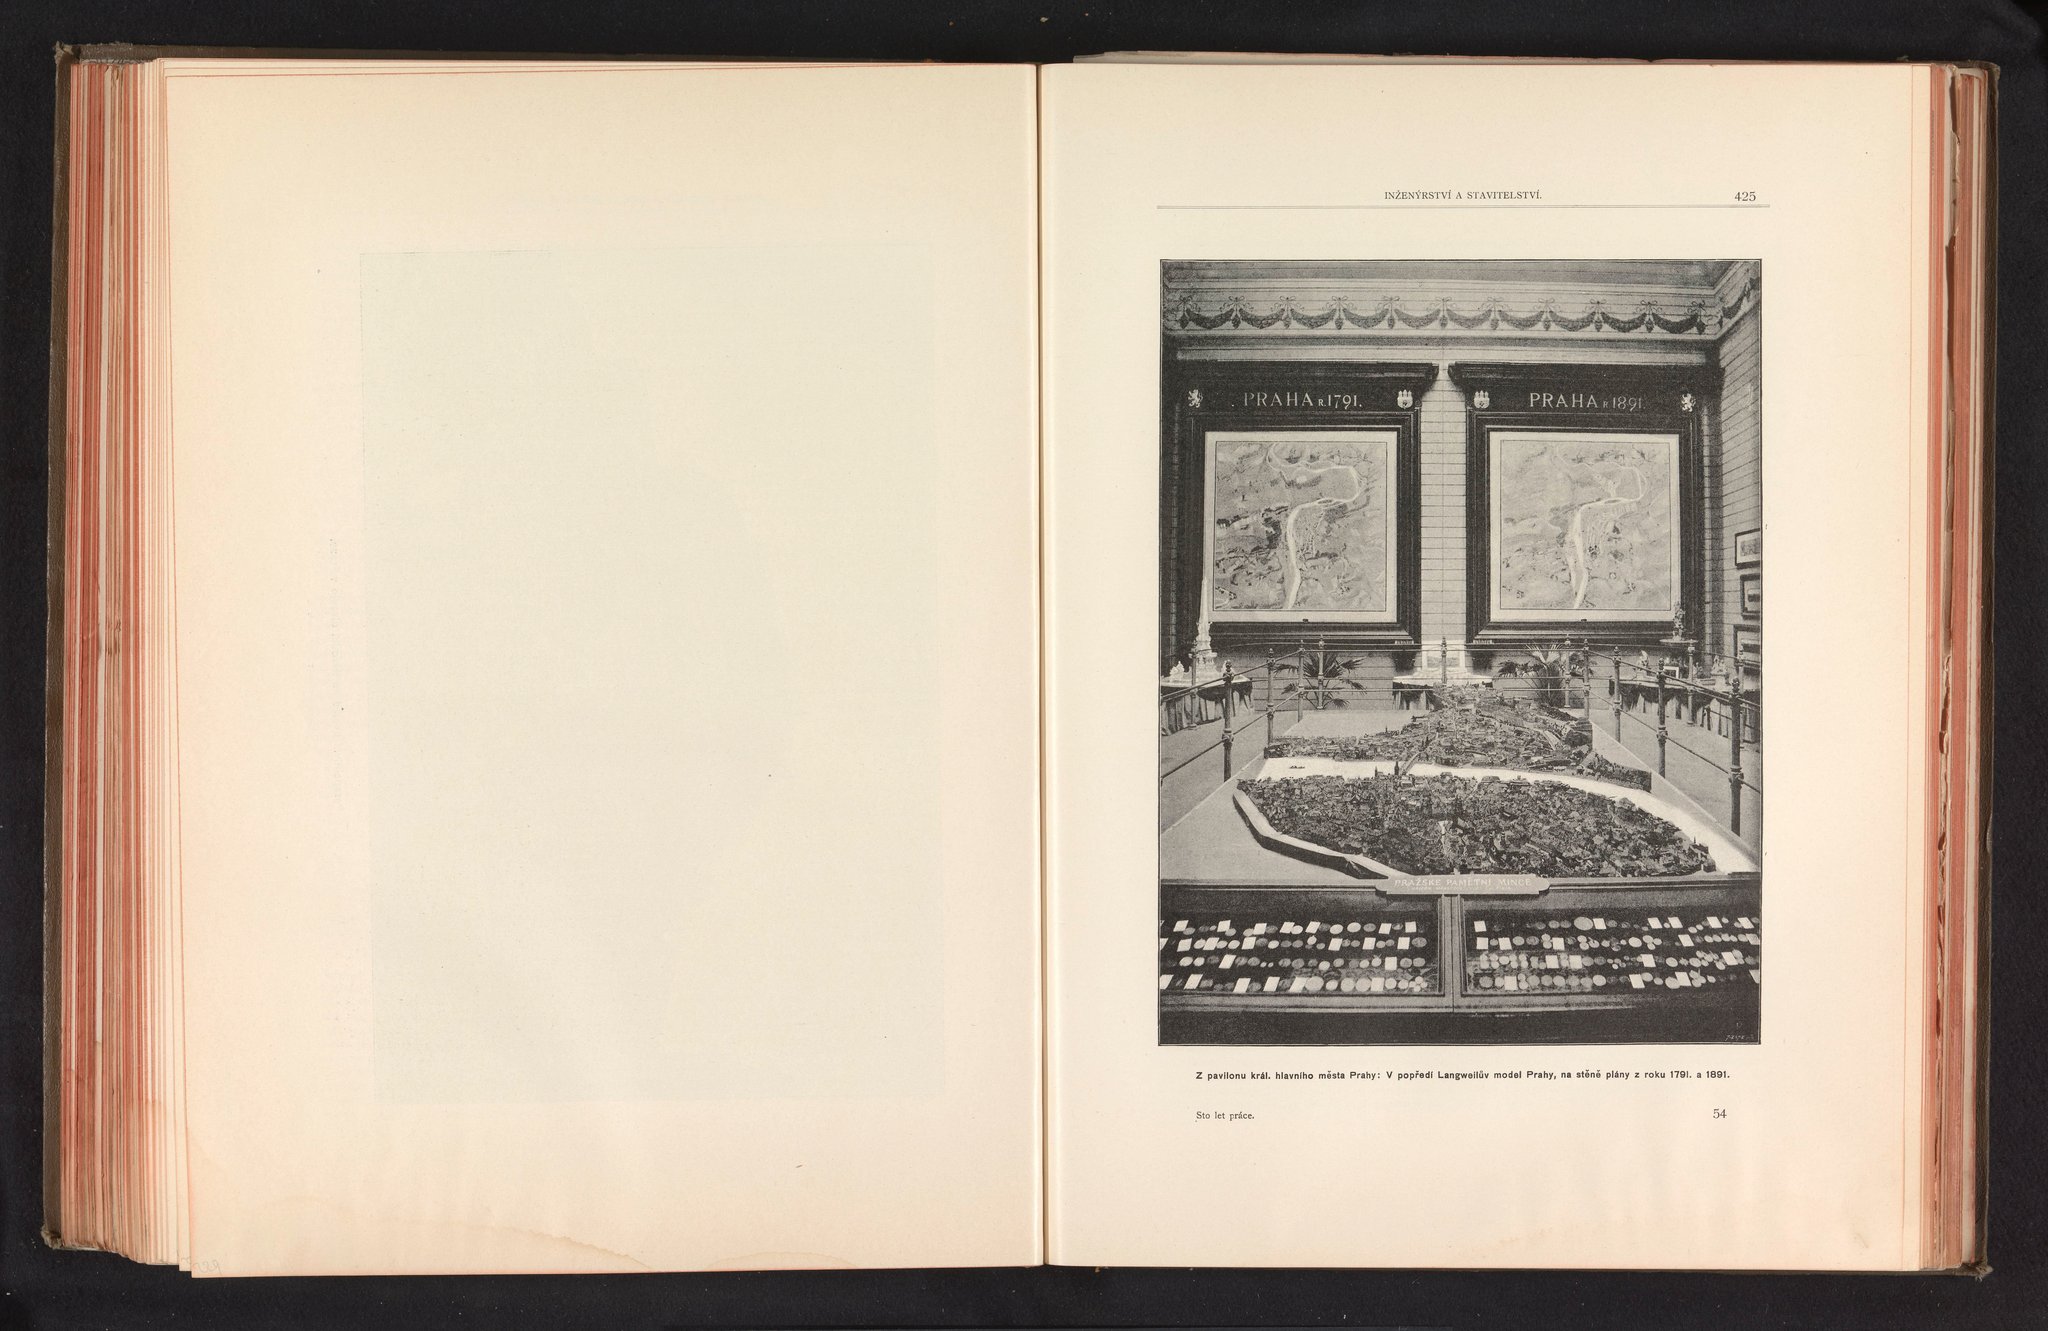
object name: photomechanical print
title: Model van Praag en twee kaarten van de stad in het koninklijk paviljoen te Praag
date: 1891-1895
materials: paper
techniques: autotype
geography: prague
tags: maps, atlases, interior ~ representation of a building, prospect of city, town panorama, silhouette of city